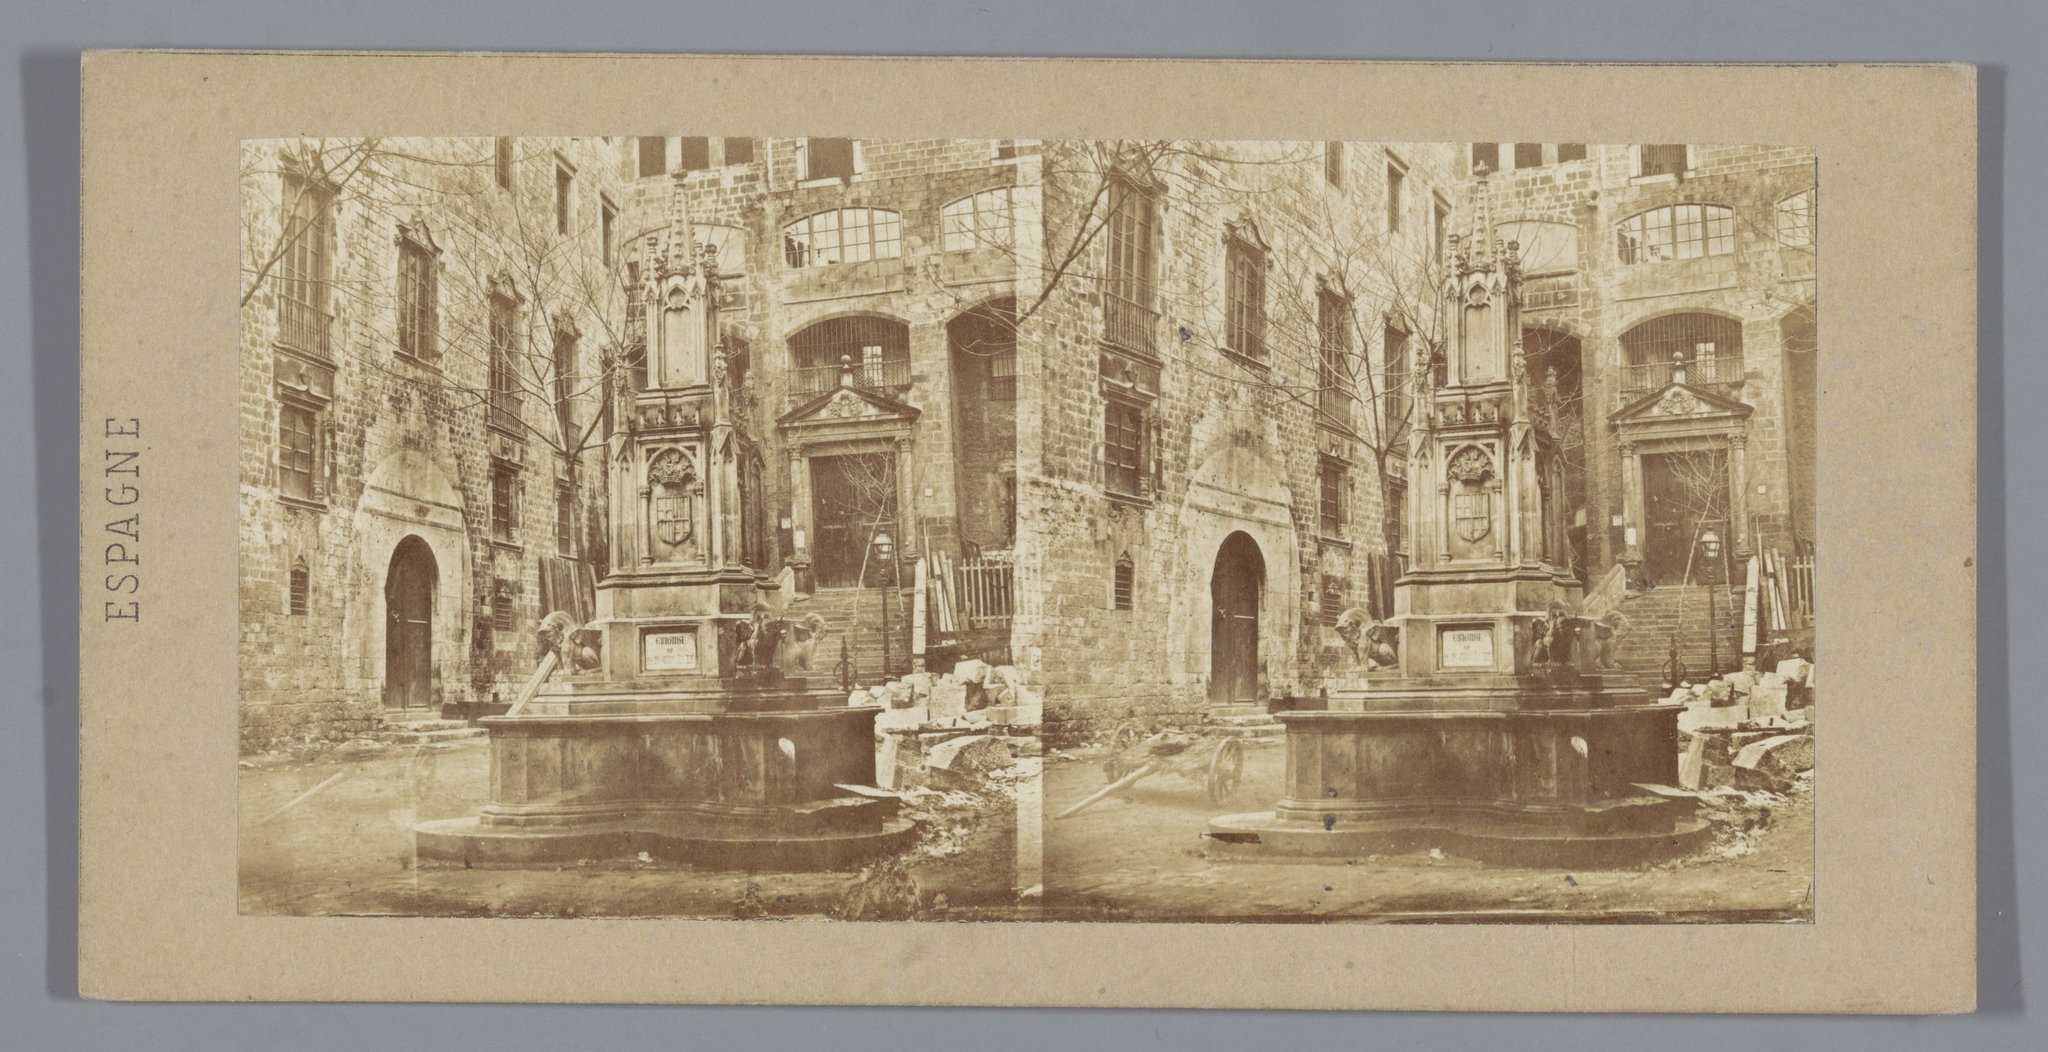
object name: stereograph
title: Gezicht op een binnenplaats te Barcelona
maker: Anonymous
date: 1850-1880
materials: cardboard, photographic support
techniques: albumen print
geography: barcelona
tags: façade of inner court, ornamental fountain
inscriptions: number: ‘No 232.’, inscription: ‘Maison du Grand Inquisiteur, à Barcelonne’